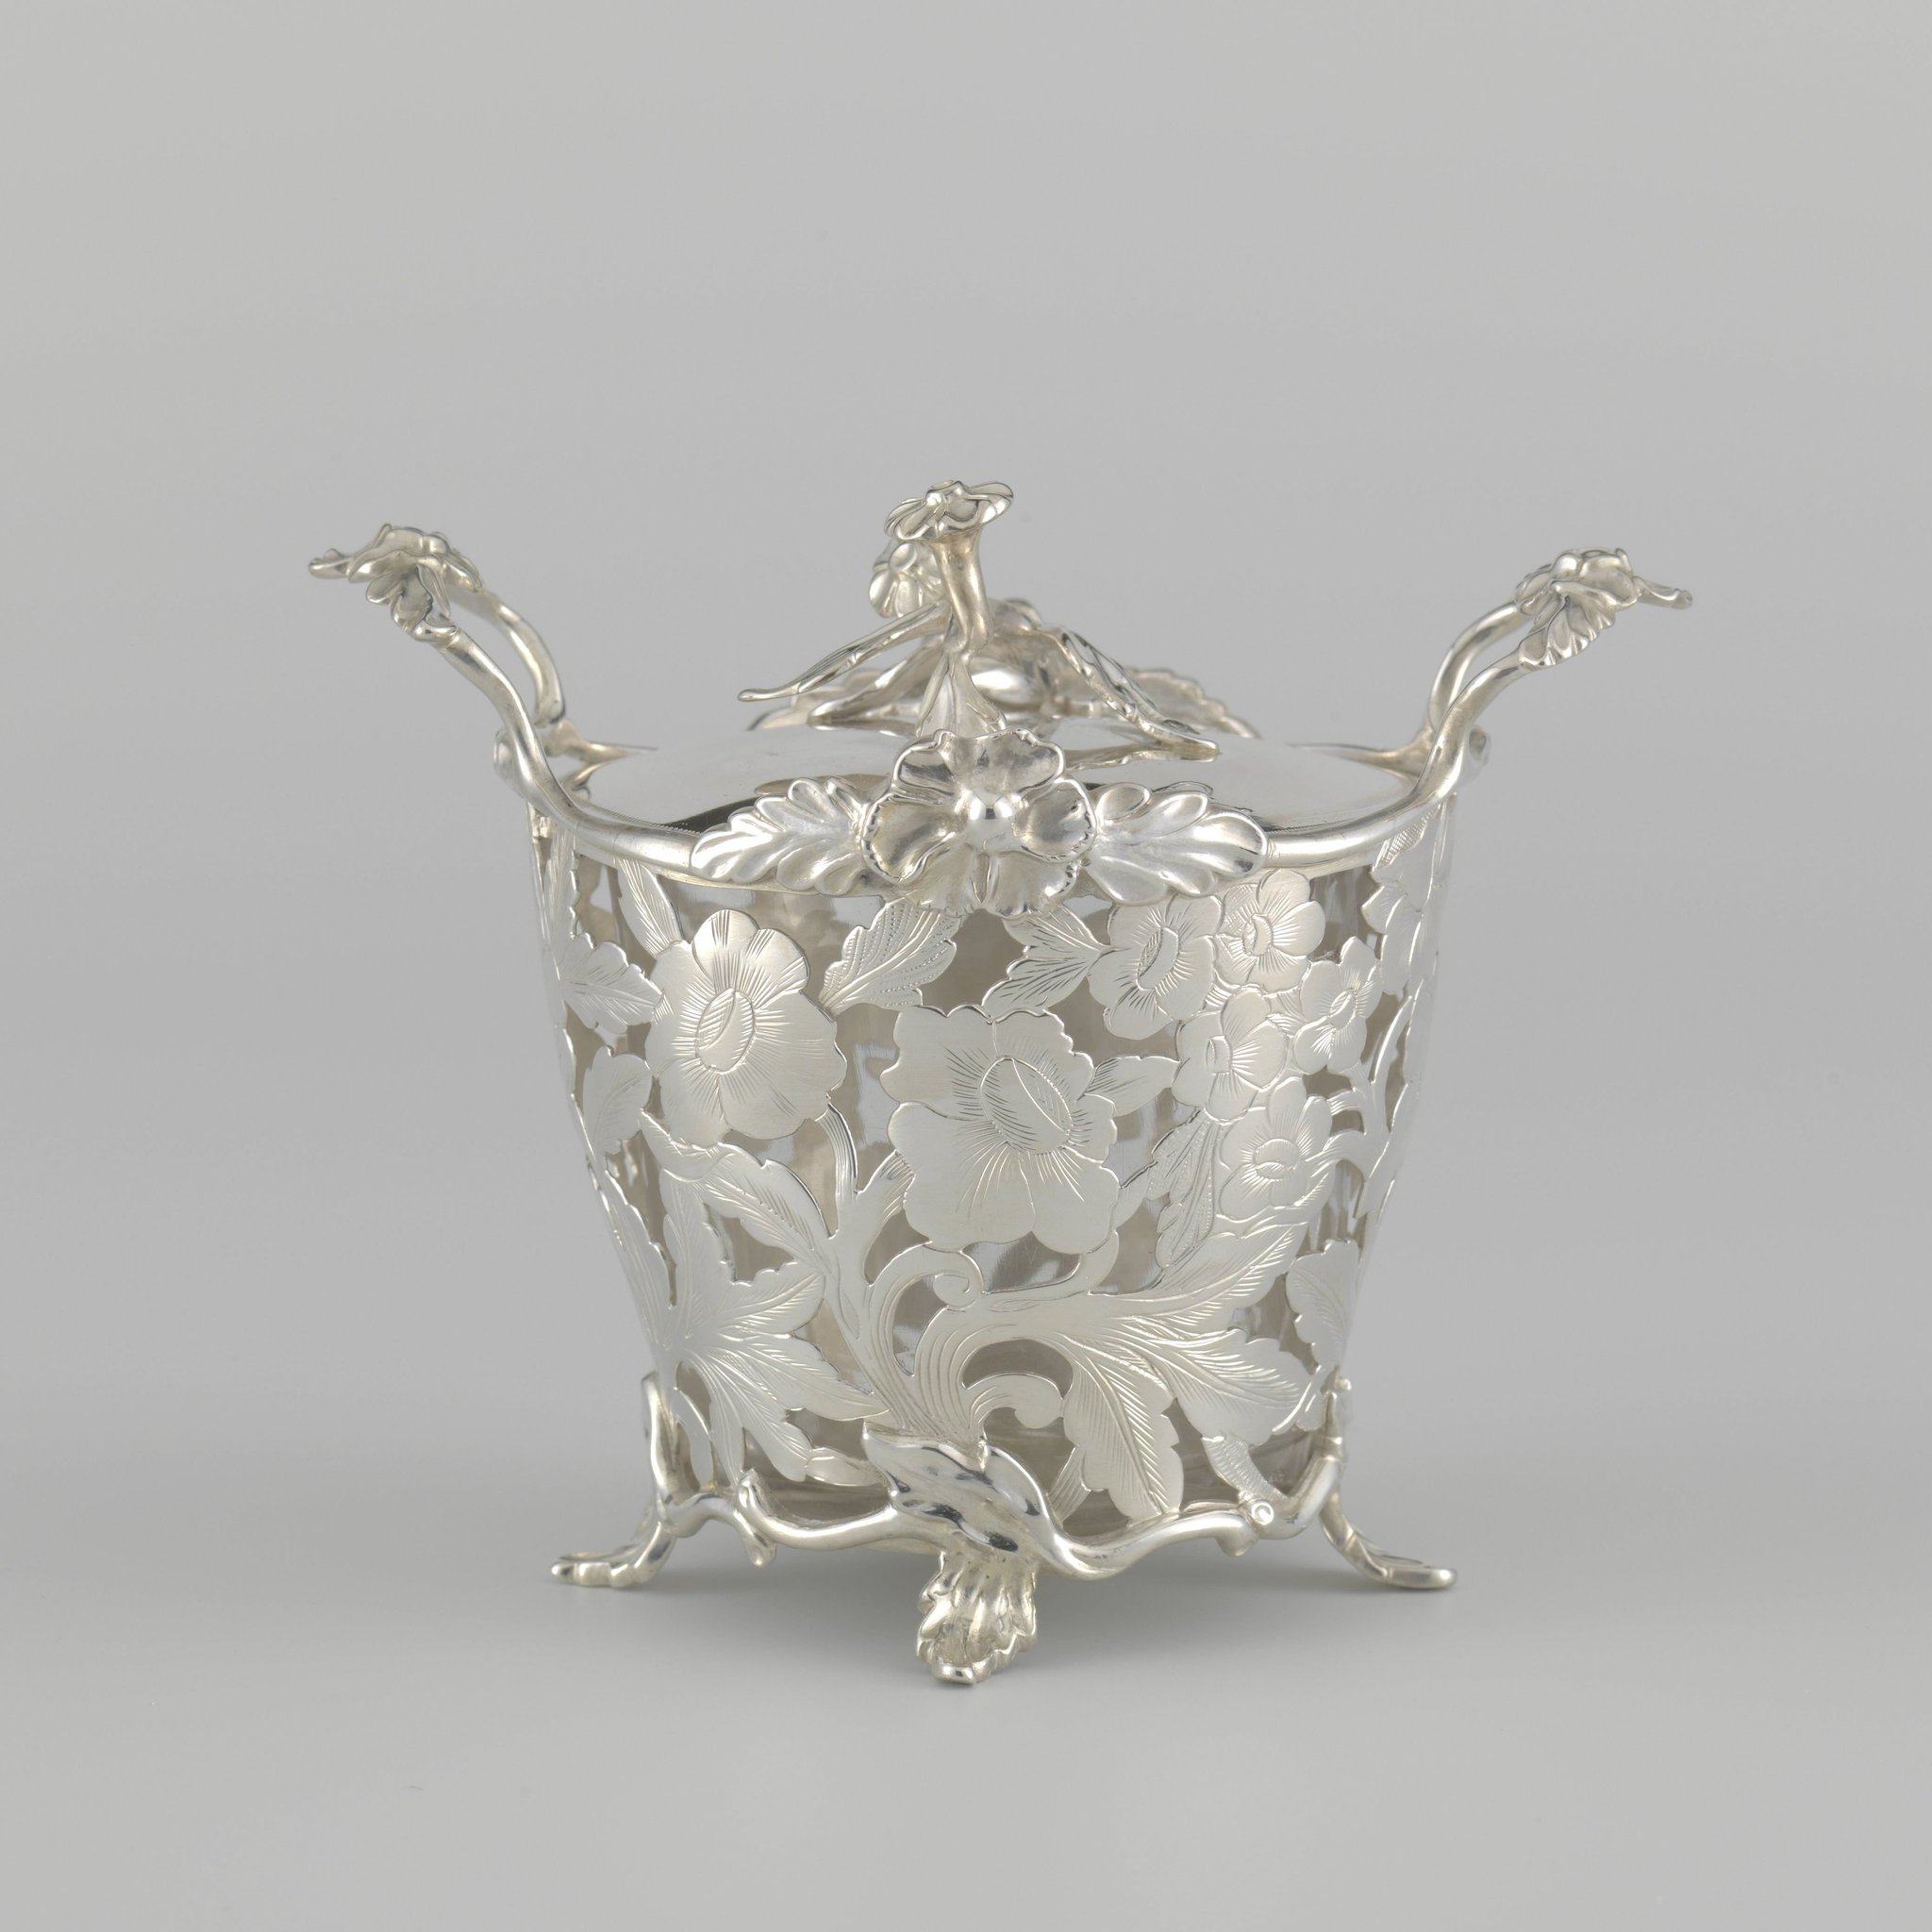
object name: mustard pot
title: Mosterdpot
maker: martinus van stapele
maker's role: silversmith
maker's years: 1731-1803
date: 1780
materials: glass, silver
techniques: casting, metalworking, sawing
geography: the hague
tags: flowers ~ ornament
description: Mustard pot. Silver. The Hague, 1780, by Martinus van Stapele.